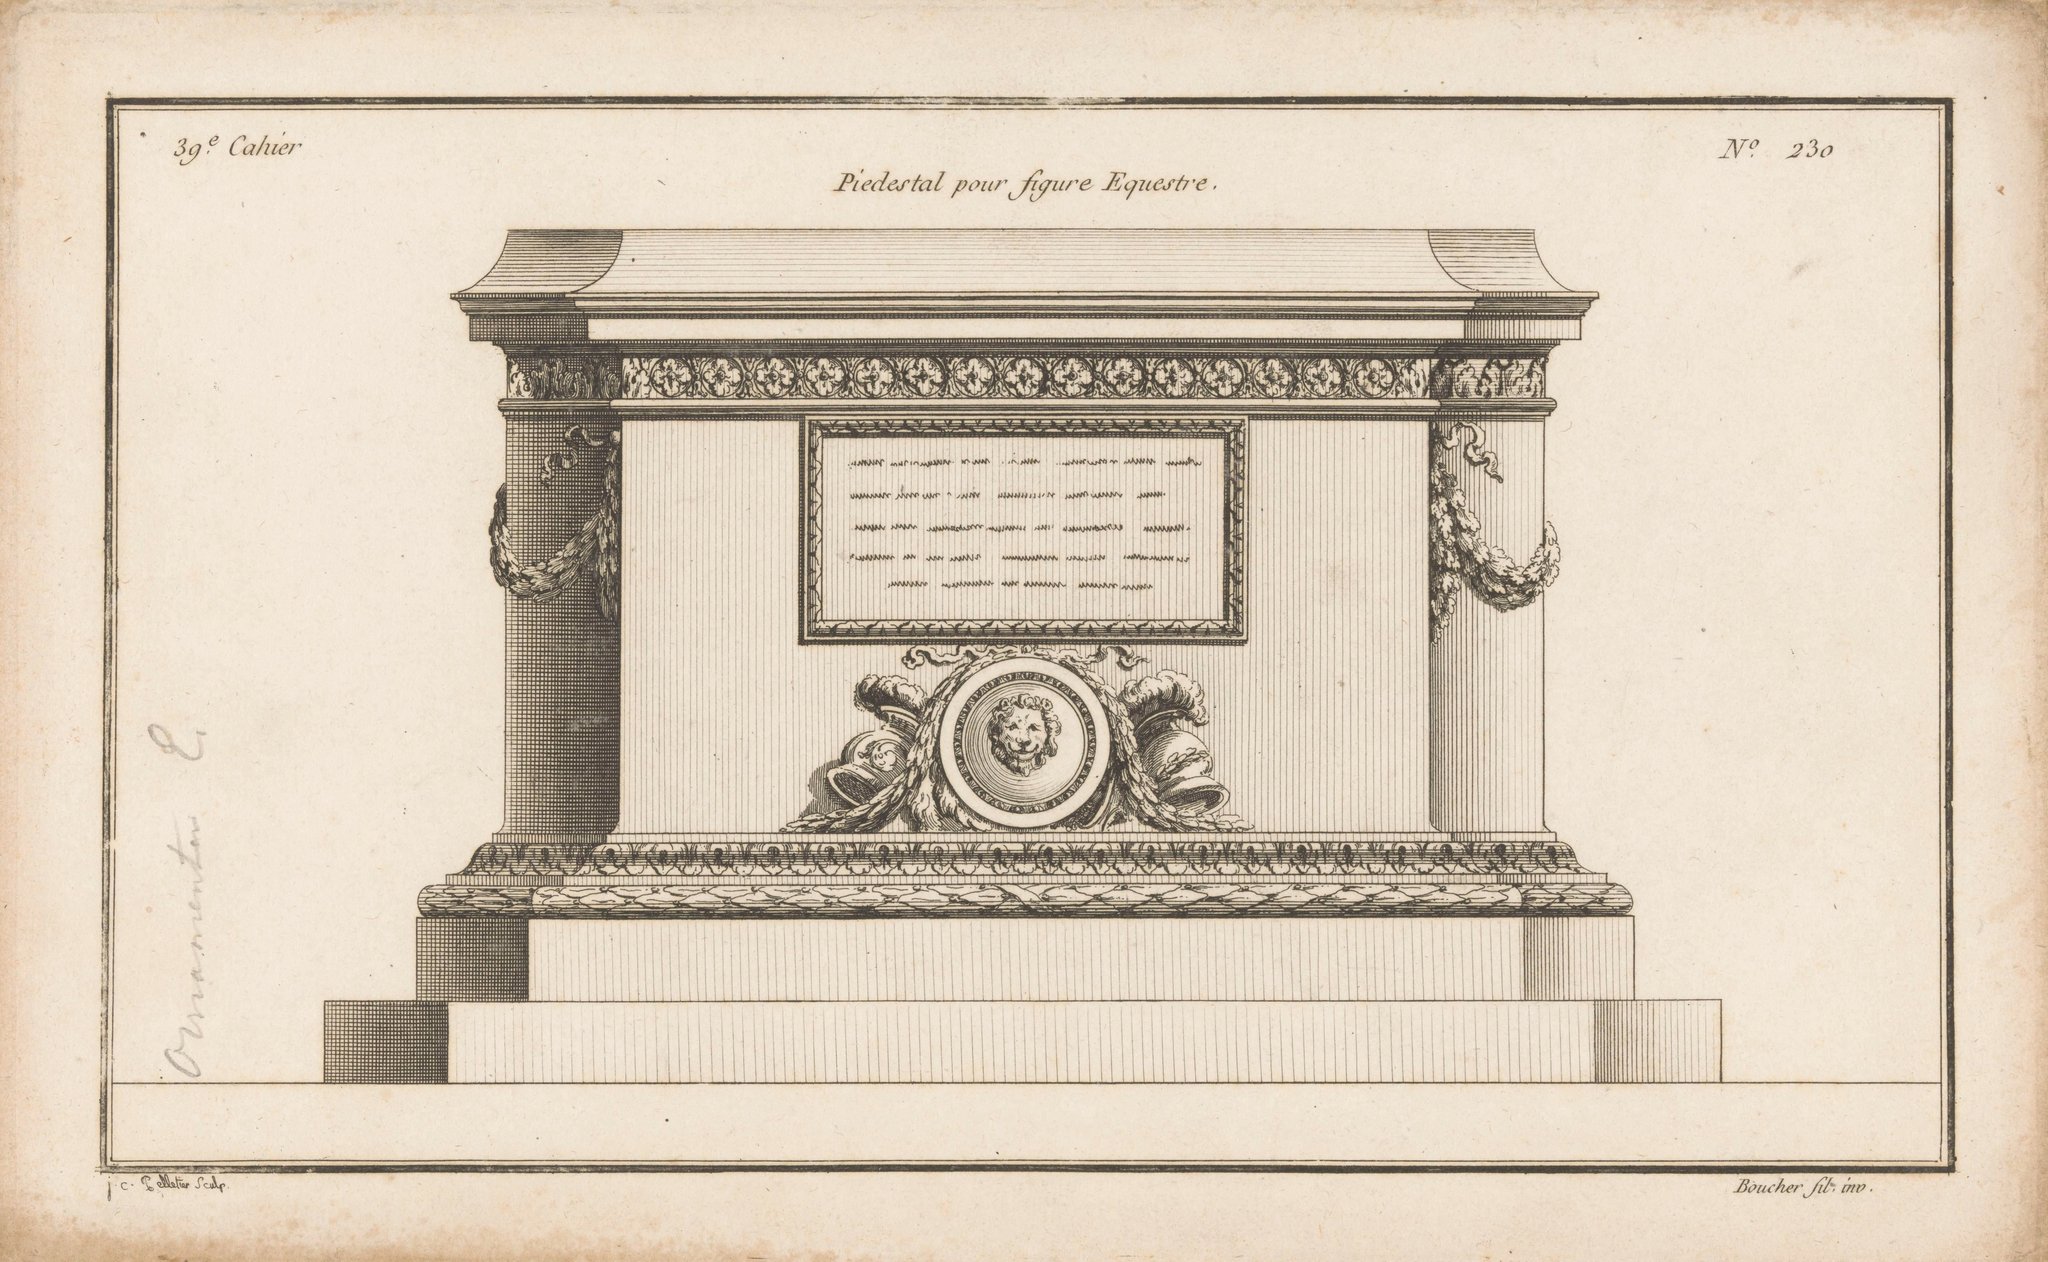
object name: ornament print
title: Voetstuk met helmen en schild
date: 1772-1779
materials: paper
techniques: engraving, etching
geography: paris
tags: helmet, protective weapons: shield, pedestal of a piece of sculpture (perhaps in the form of a herm)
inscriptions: collector's mark: Lugt 2760, collector's mark: Lugt 2228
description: Een voetstuk met een rechthoekig tablet waaronder twee helmen en een schild met leeuwenkop. Prentnummer 230.